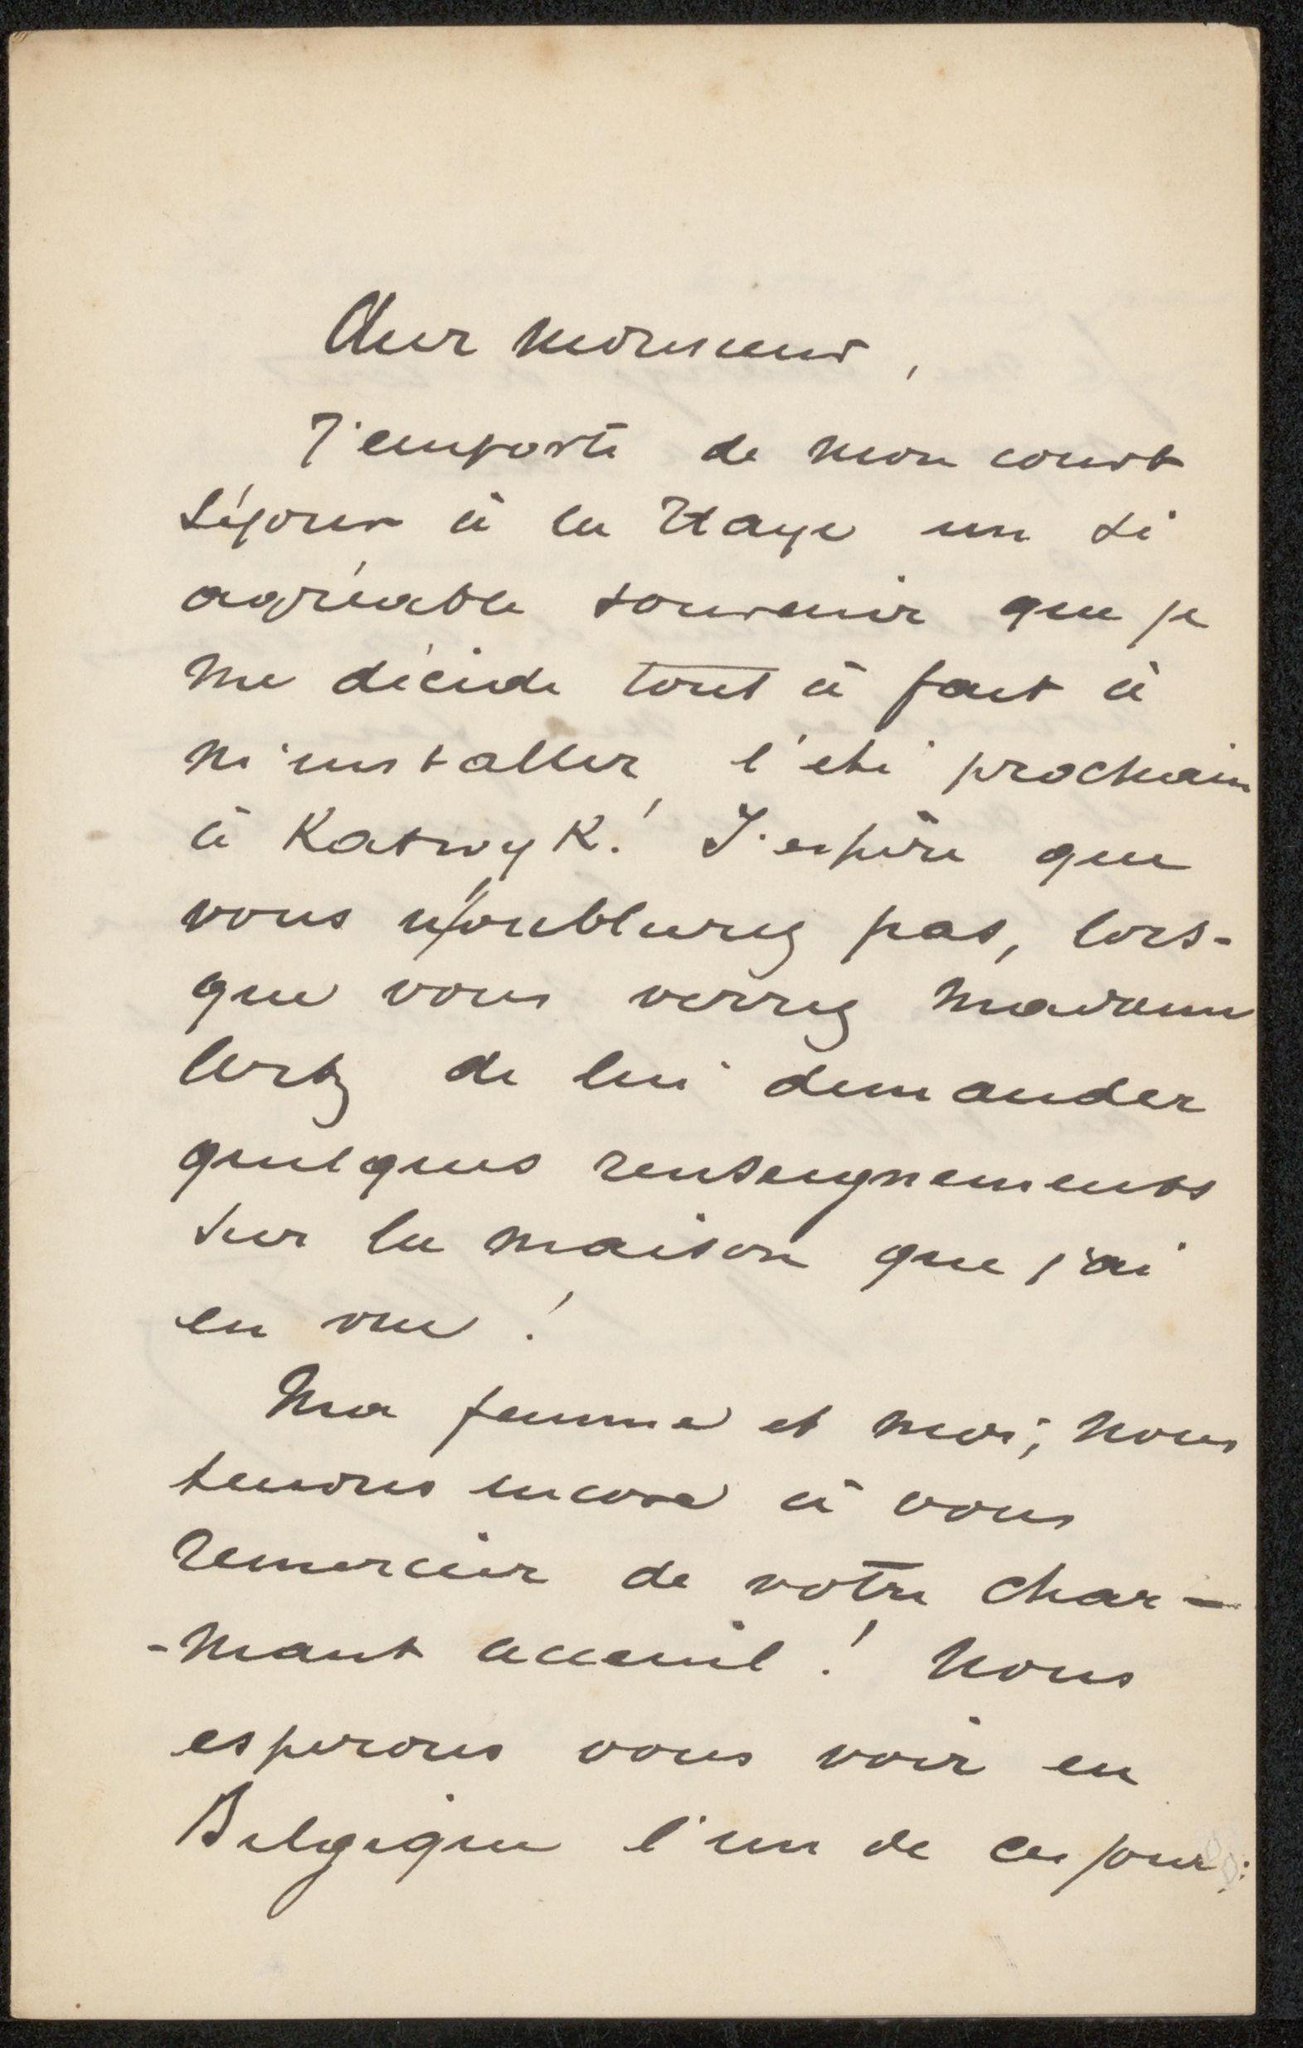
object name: letter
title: Brief aan Philip Zilcken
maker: albert baertsoen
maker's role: draughtsman, print maker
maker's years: 1866-1922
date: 1876-1922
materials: ink, paper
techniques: pen, writing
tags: the hague, painter, philip zilcken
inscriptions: collector's mark: ‘RPK’, watermark